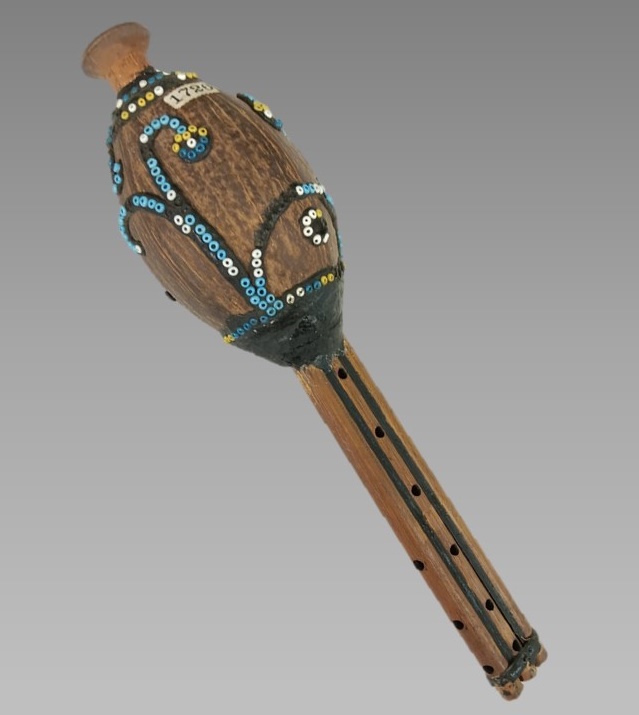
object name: reed pipe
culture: melanesian, fijian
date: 1867-1900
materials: bamboo, shell, wood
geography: fiji